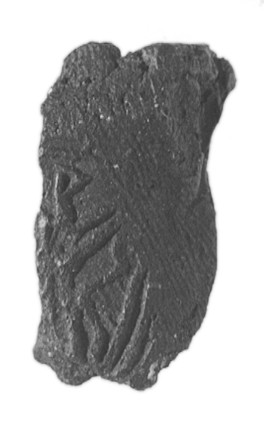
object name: sealing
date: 2030-1640 BCE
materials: clay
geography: egypt